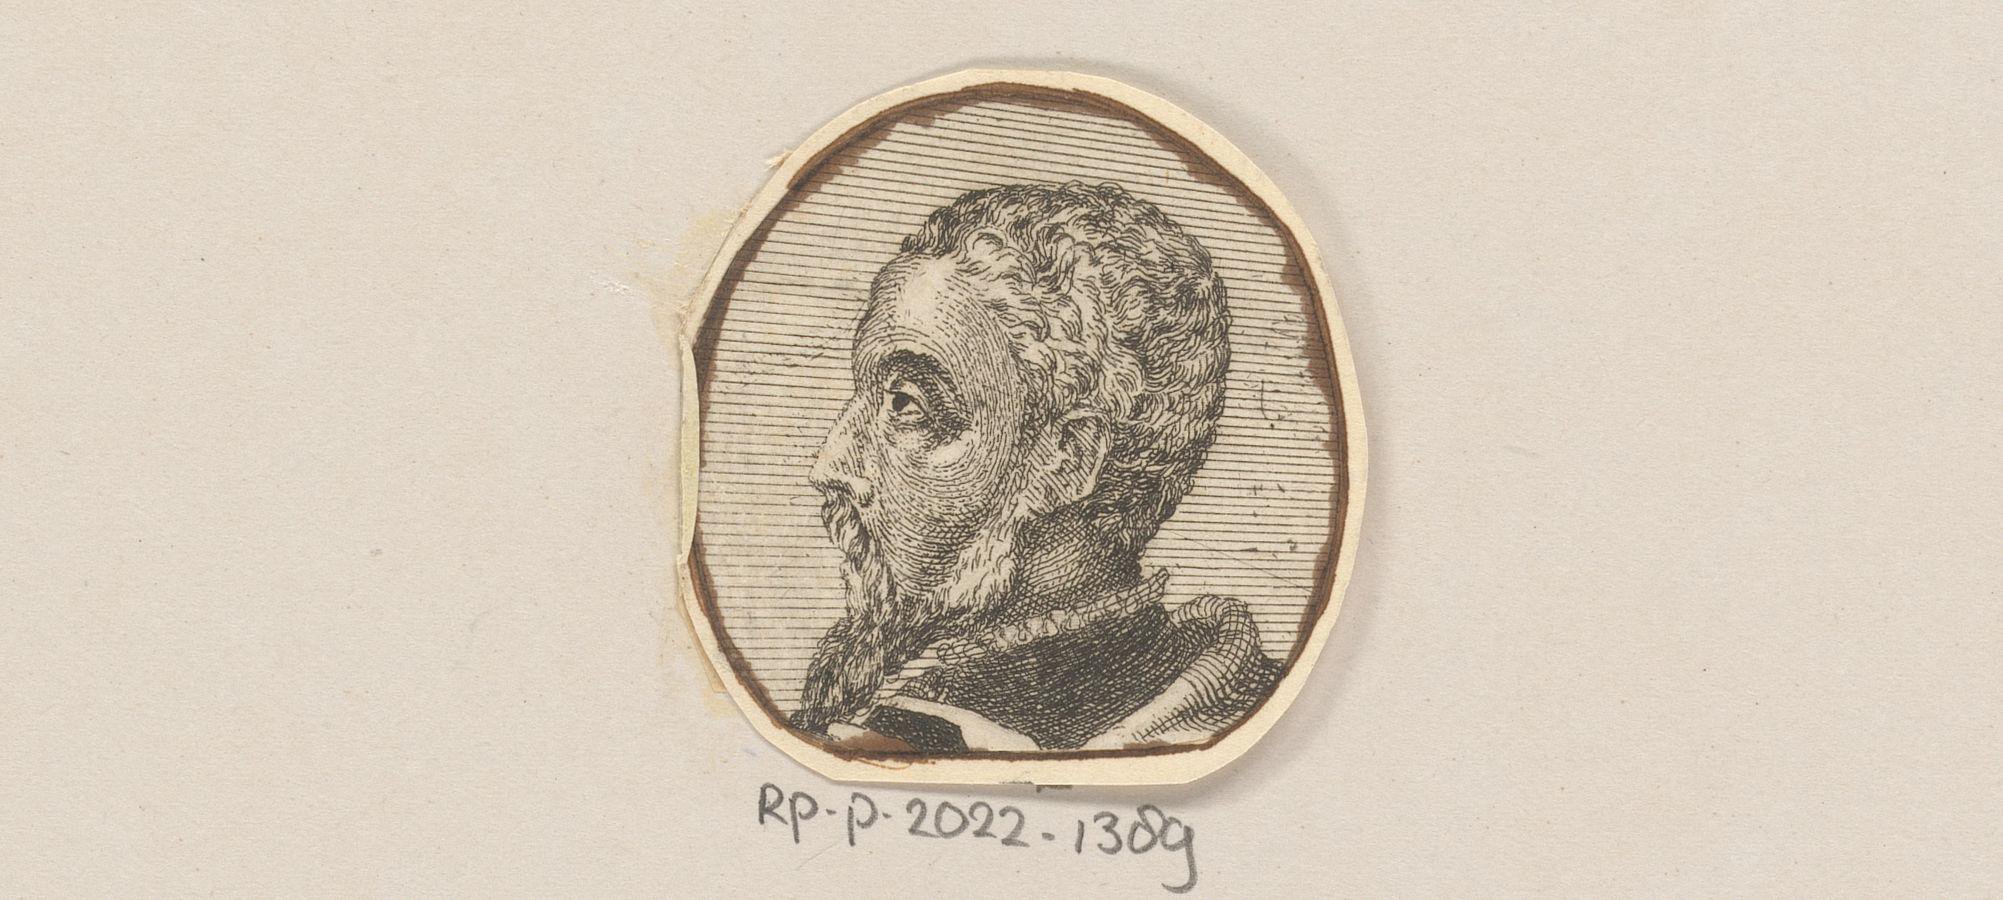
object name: print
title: Portret van Anthonis Mor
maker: jan l admiral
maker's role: draughtsman, print maker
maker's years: 1699-1773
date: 1764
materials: paper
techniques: etching, snipping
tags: utrecht, painter, draughtsman, anthonis mor, historical persons, portrait, self-portrait of painter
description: Prent waarschijnlijk uit: Mander, Karel van, Jongh, Jacobus de (vert.). Het leven der doorluchtige Nederlandsche en eenige Hoogduitsche schilders. Amsterdam: Steven van Esveldt, 1764.